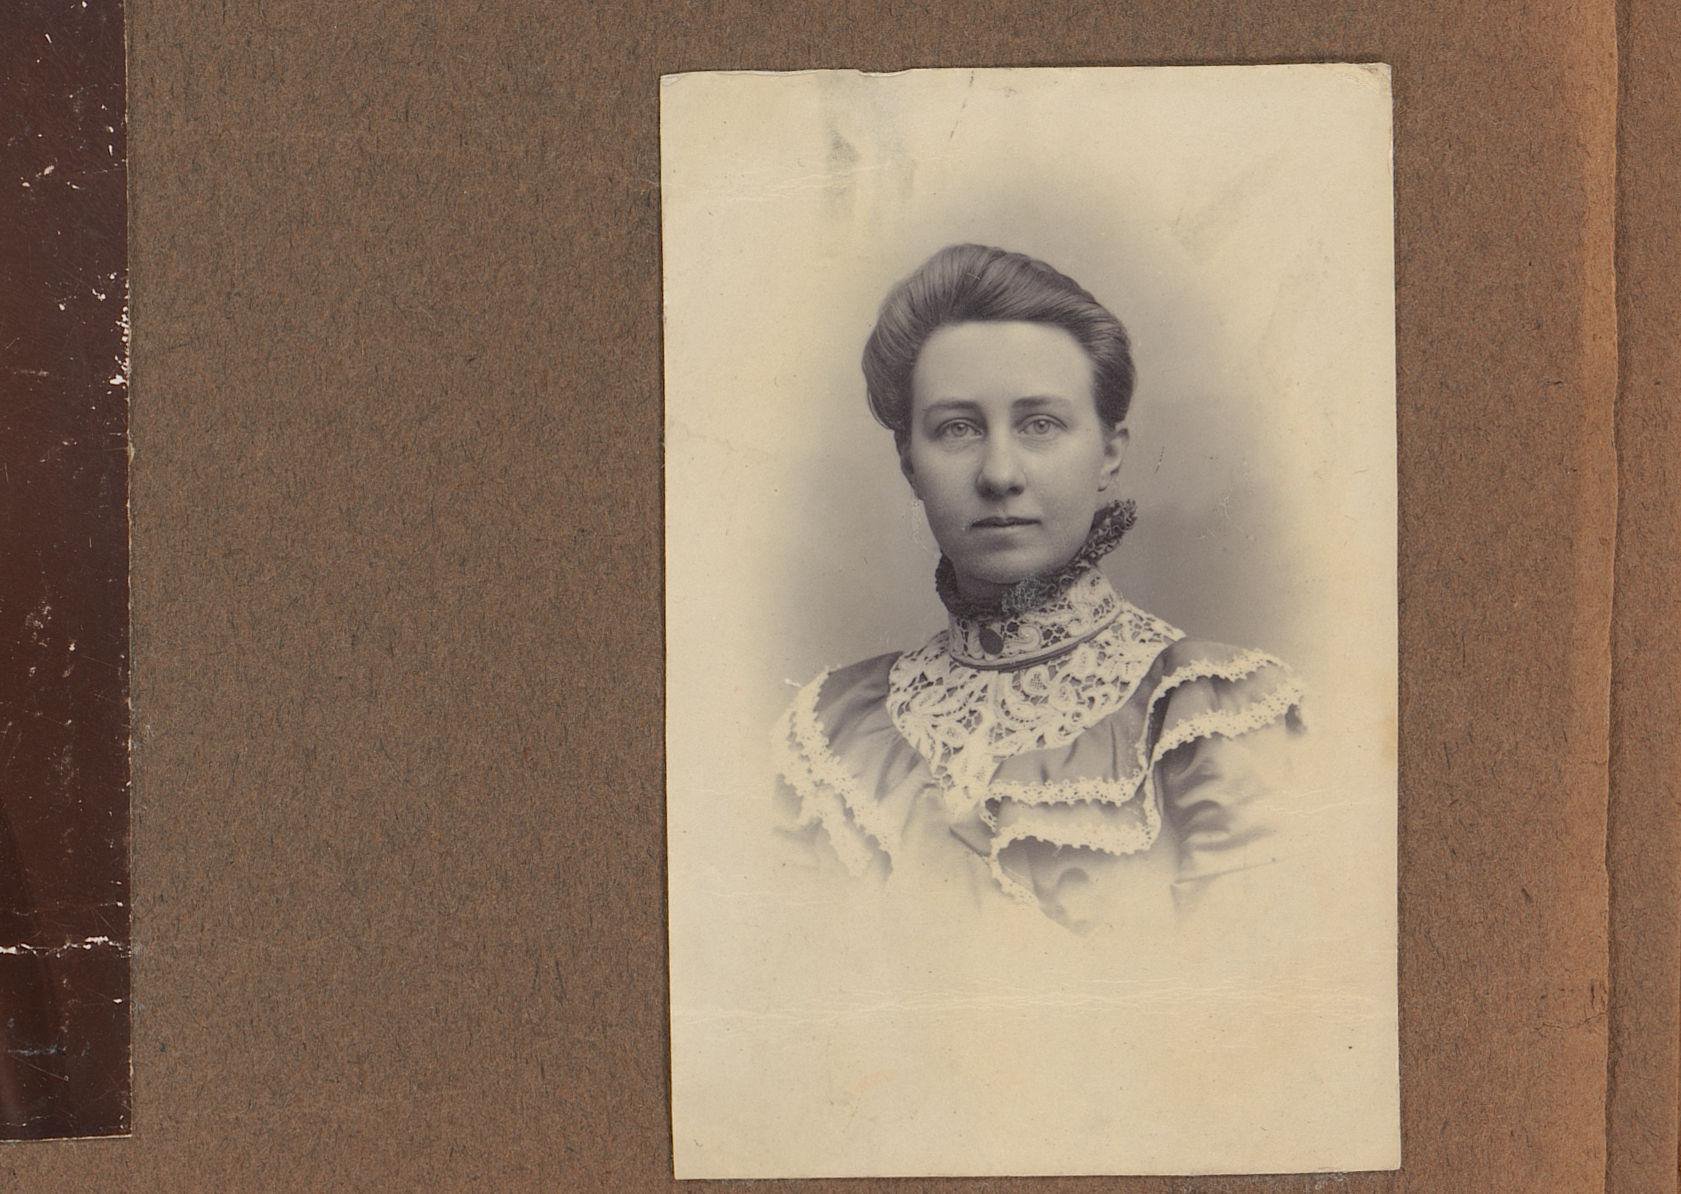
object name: photograph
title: Portret van jonge vrouw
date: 1870-1920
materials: photographic support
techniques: photography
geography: netherlands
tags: netherlands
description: Foto op bruin albumblad 35 van familiealbum van Alphons Diepenbrock.